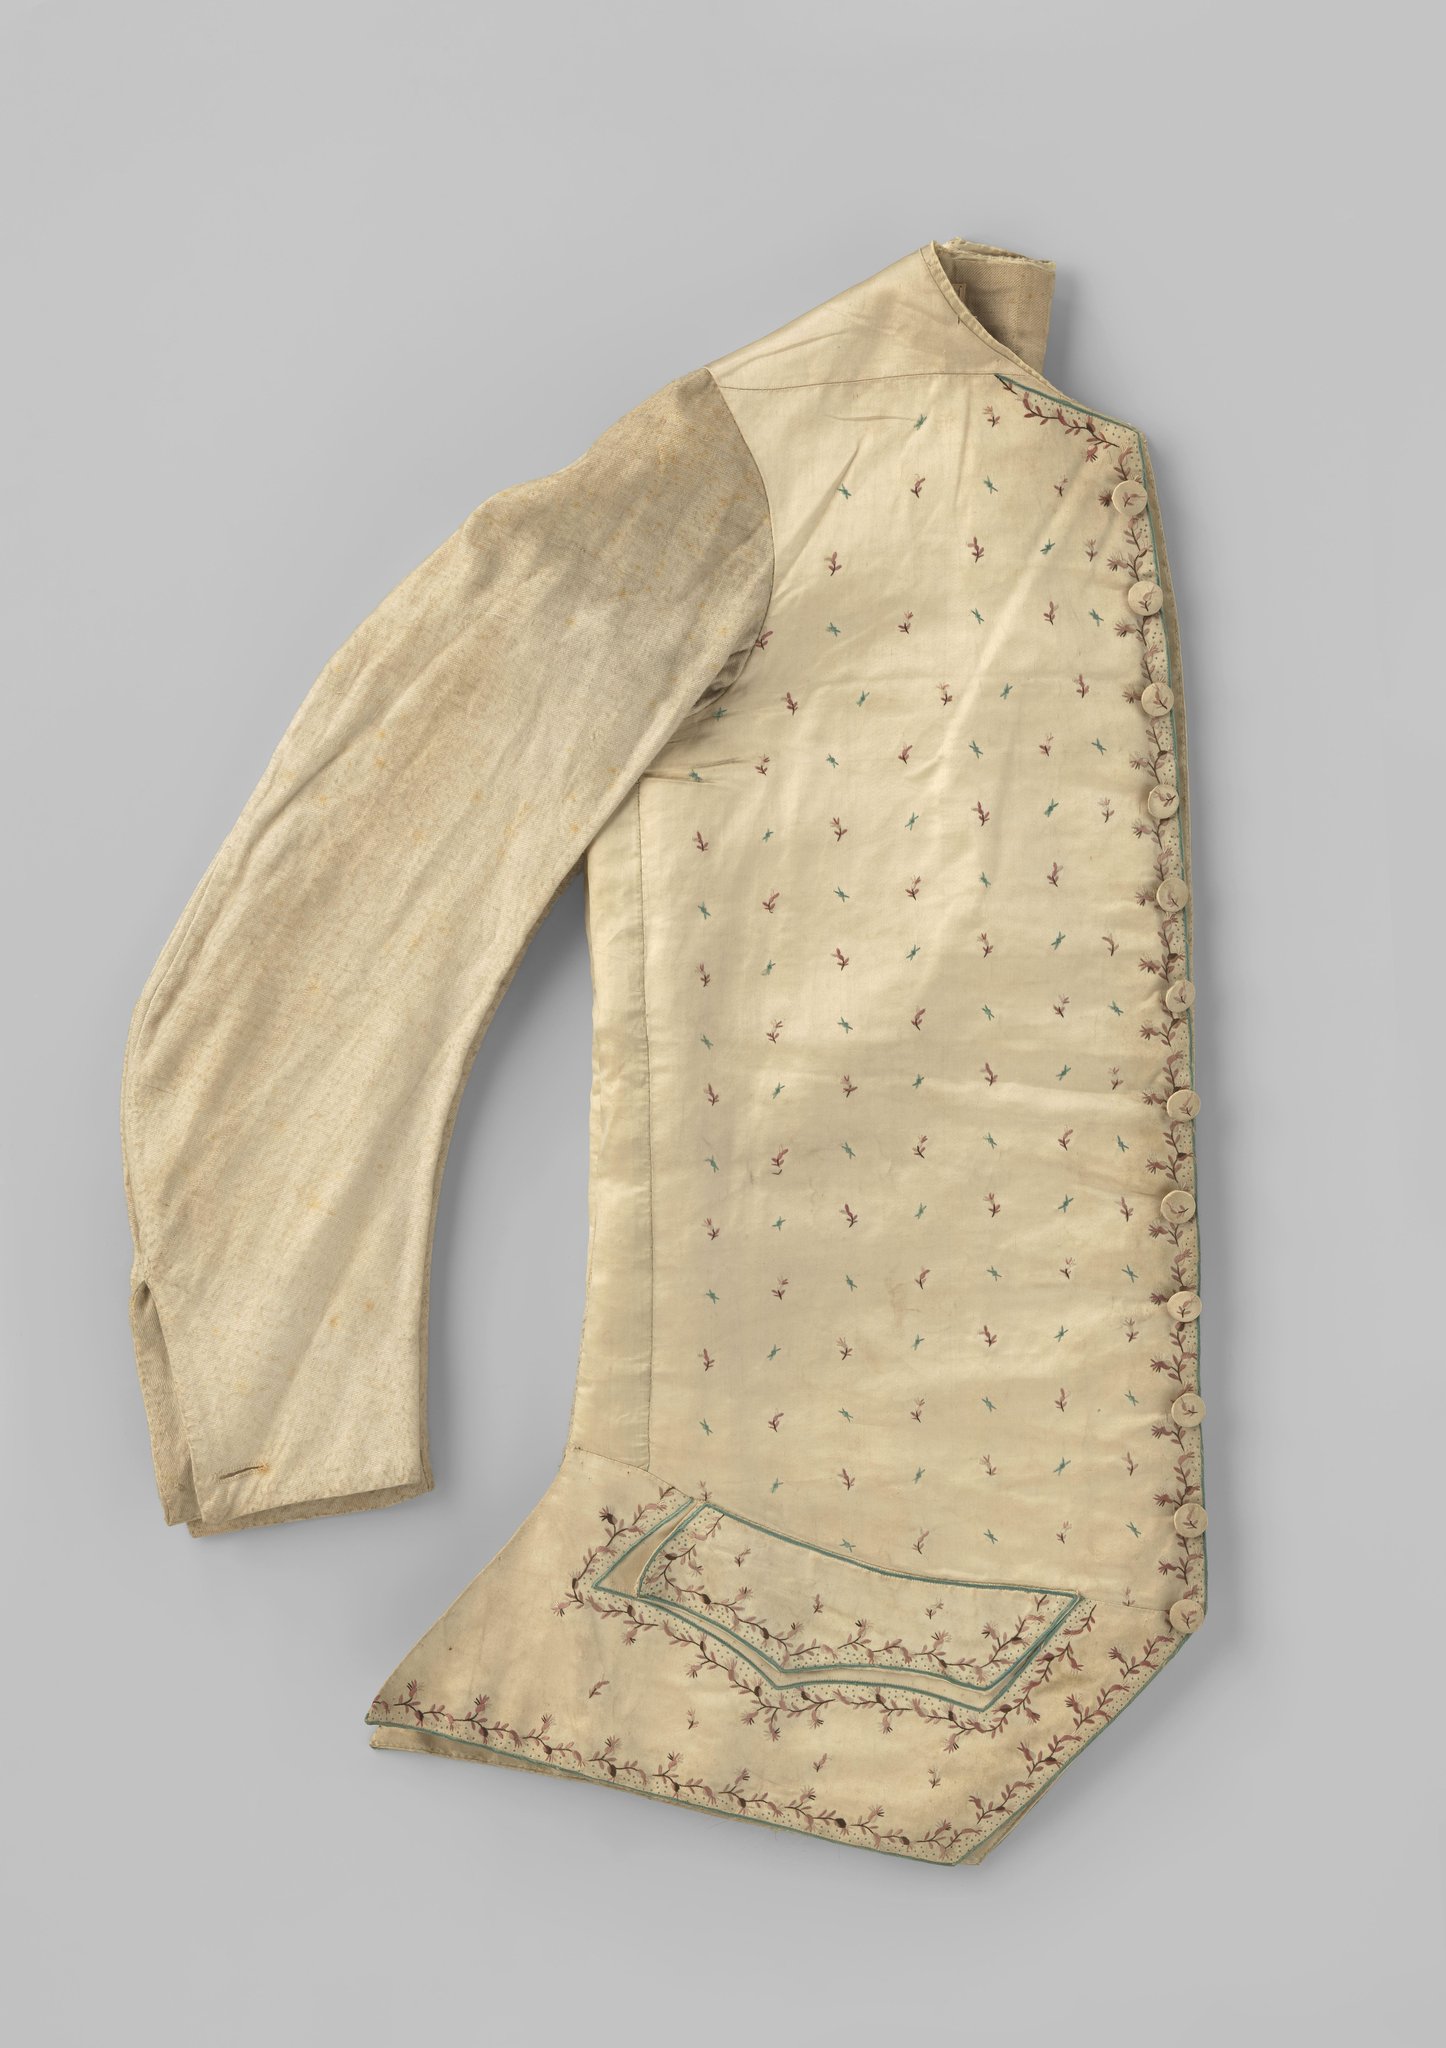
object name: main garment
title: Vest van crème satijn, met geborduurd floraal strooimotief in bruin, crème en groen en fijne bloem- en bladranken in bruin, roze, crème en groen; mouwen en rug van wit flanel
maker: Anonymous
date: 1770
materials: textile, linen, silk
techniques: embroidered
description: Vest van wit zijden satijn, geborduurde paarse en groene bloempkjes. Wit geruwd linnen mouwen. Geen kraag, gesloten rug.